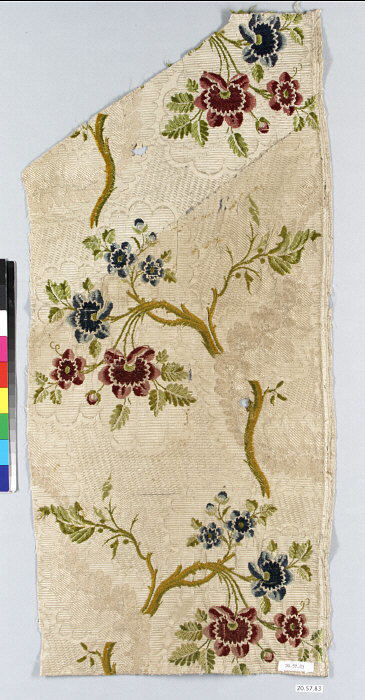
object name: piece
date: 1760-1770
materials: silk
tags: flowers,leaves